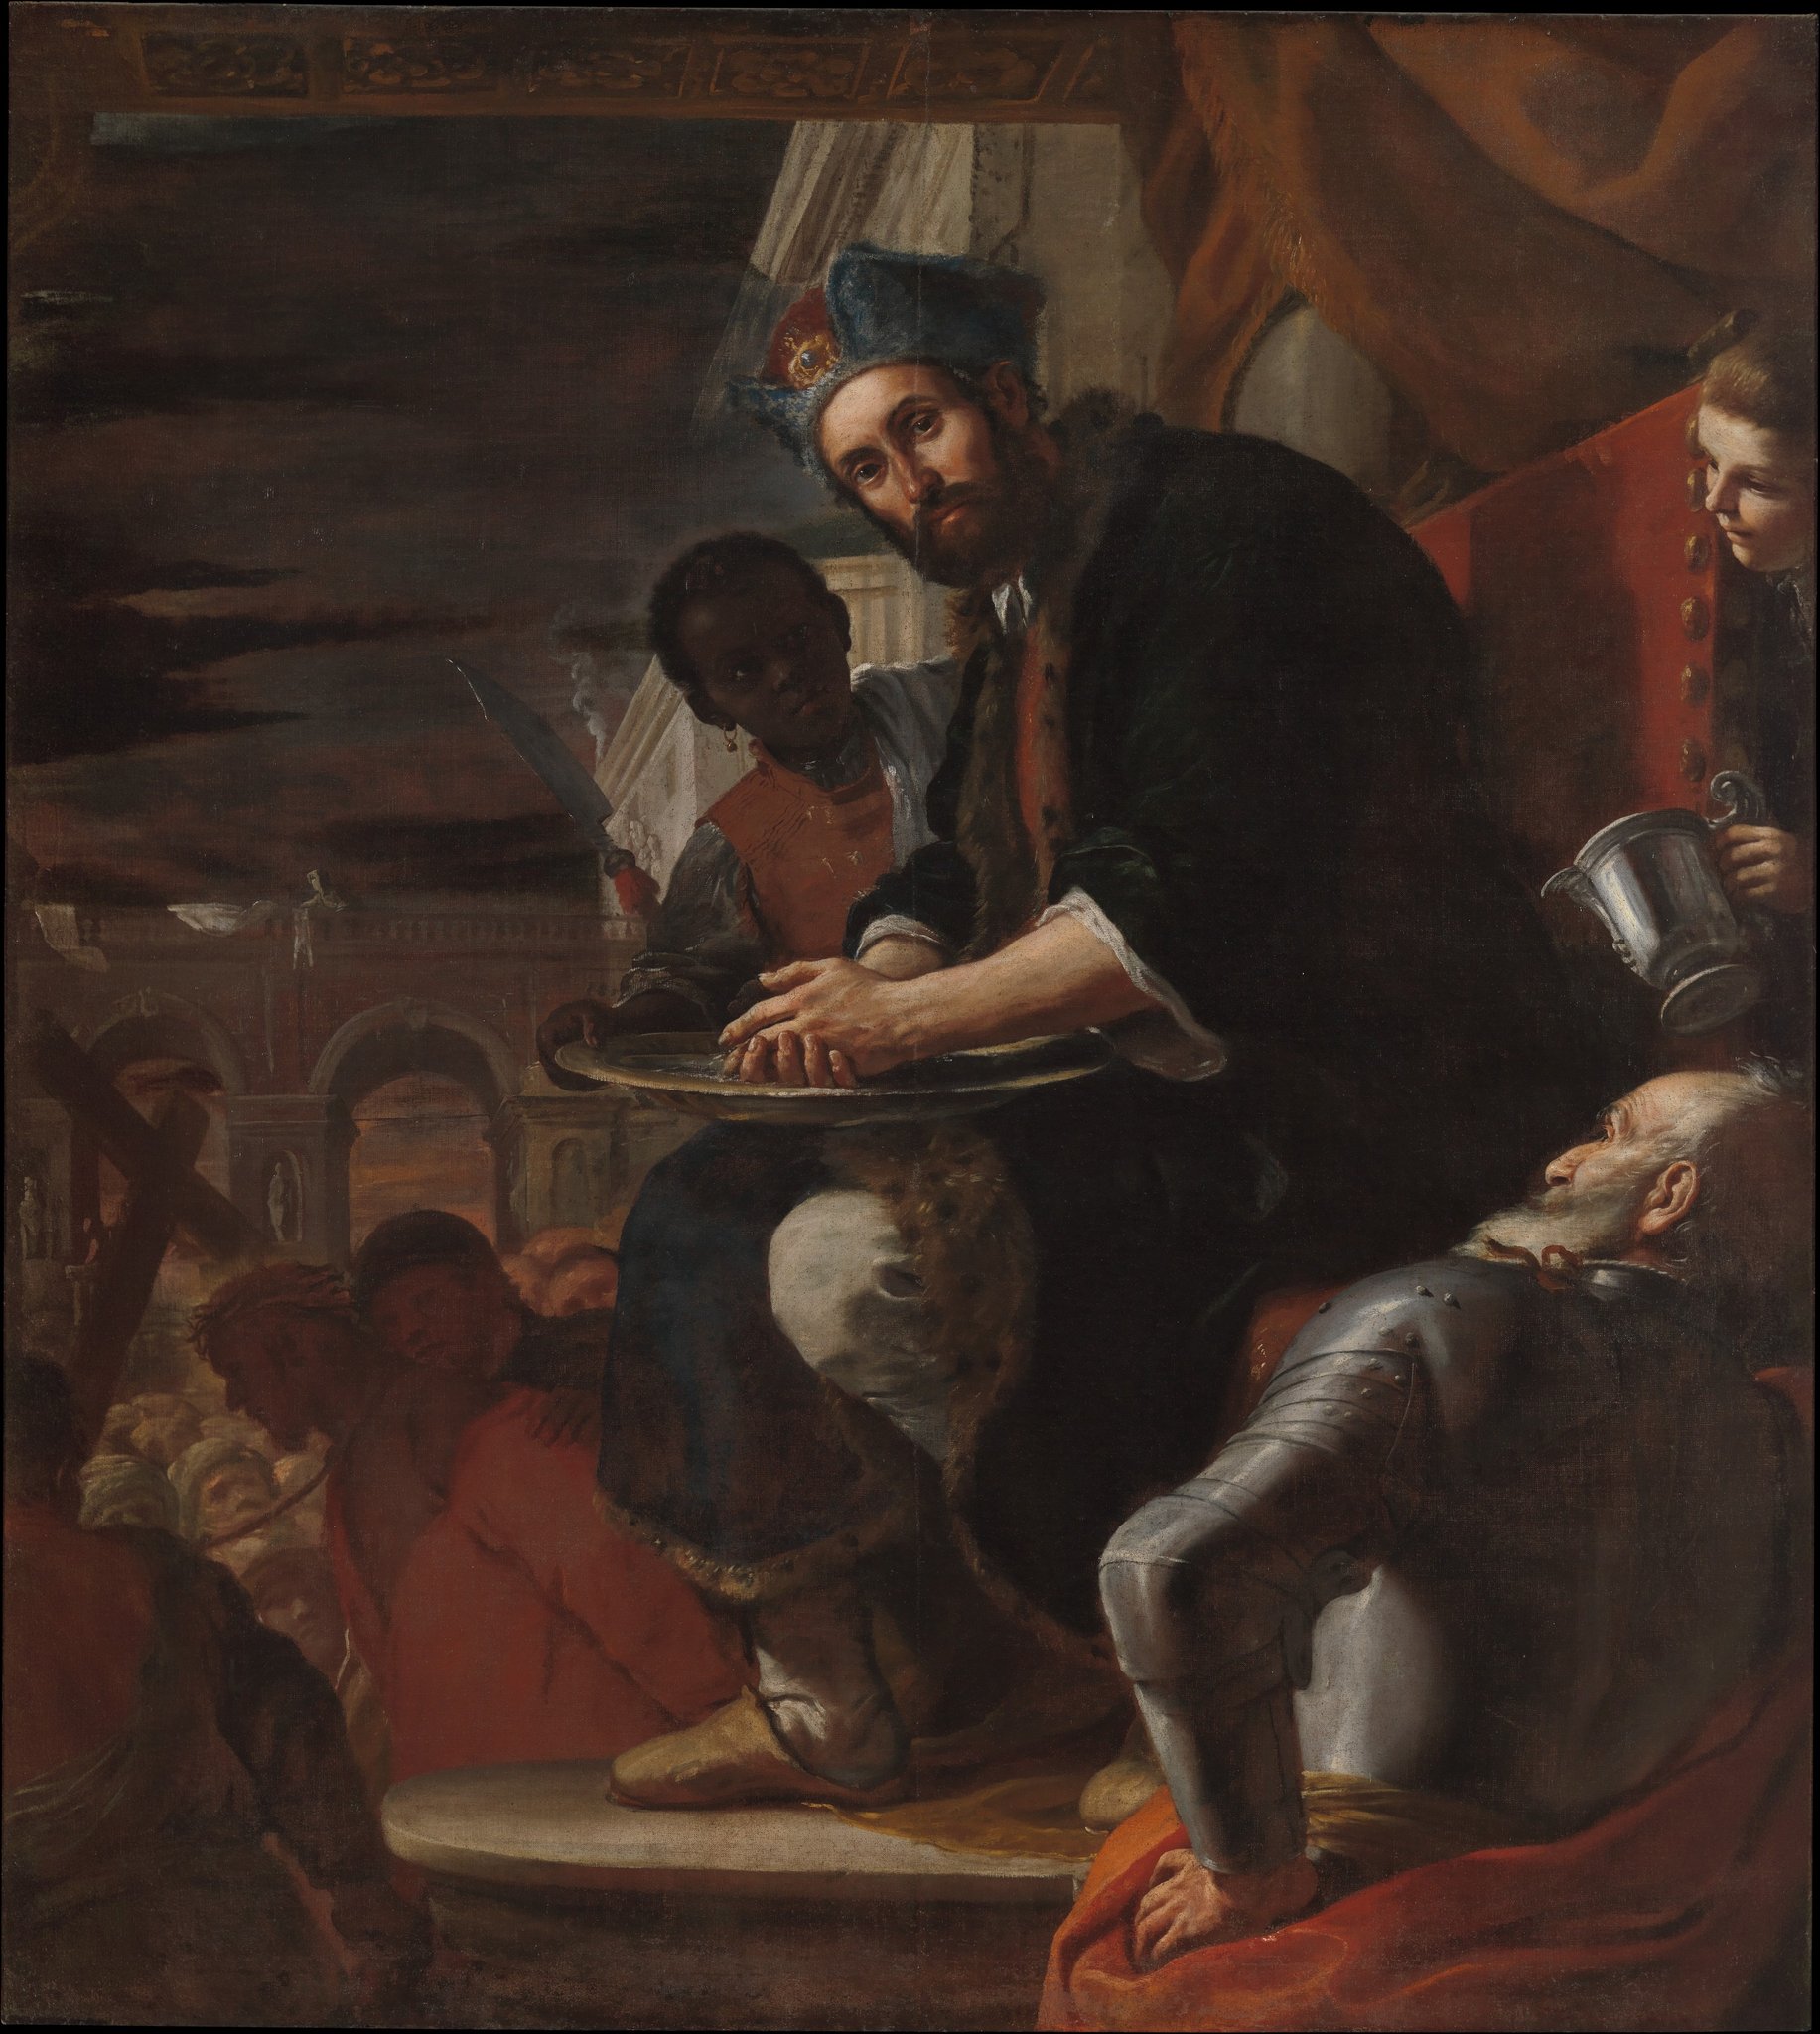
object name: painting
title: Pilate Washing His Hands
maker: mattia preti (il cavalier calabrese)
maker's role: artist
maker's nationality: italian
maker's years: 1613-1699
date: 1663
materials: canvas, oil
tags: men,christ,washing